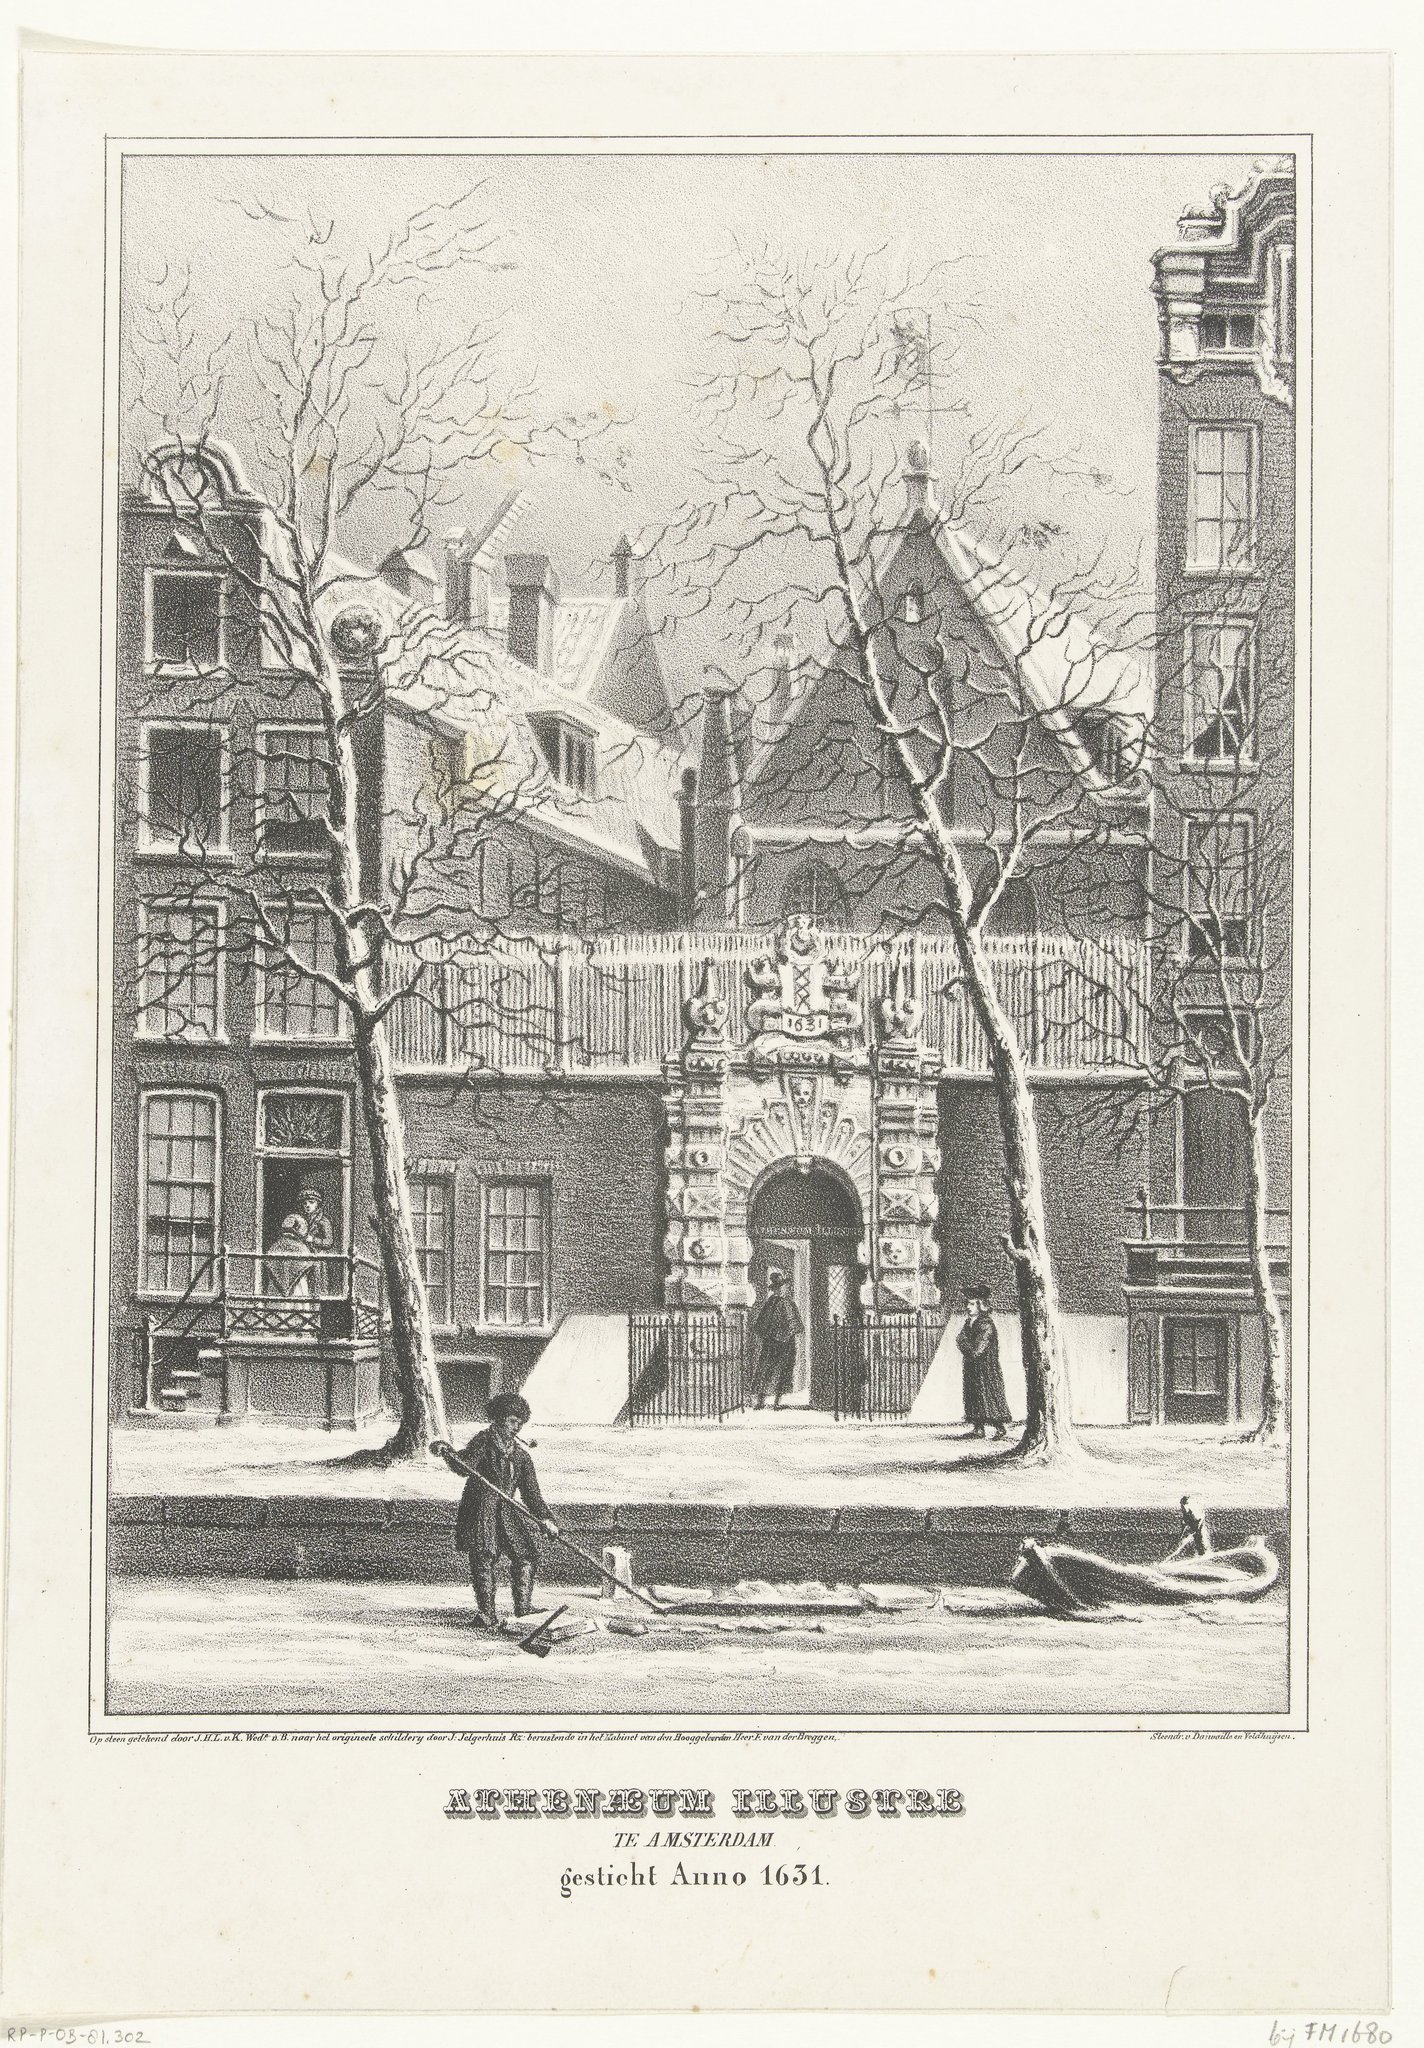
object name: print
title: Gezicht op het Athenaeum Illustre te Amsterdam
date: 1800-1899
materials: paper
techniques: lithograph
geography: netherlands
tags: university building, college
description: Gezicht op het poortje van de oude universiteit Athenaeum Illustre aan de Oudezijds Voorburgwal, gesticht in 1631. Winters stadsgezicht met een man staande op het ijs van de gracht.